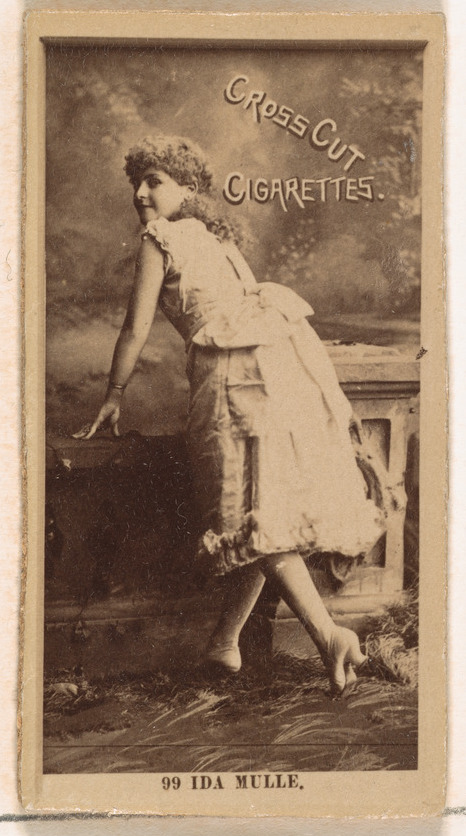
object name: print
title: Card Number 99, Ida Mulle, from the Actors and Actresses series (N145-2) issued by Duke Sons & Co. to promote Cross Cut Cigarettes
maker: w. duke, sons & co.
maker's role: publisher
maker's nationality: american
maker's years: 1870-1920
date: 1880-1889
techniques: albumen silver print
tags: portraits,women,actresses